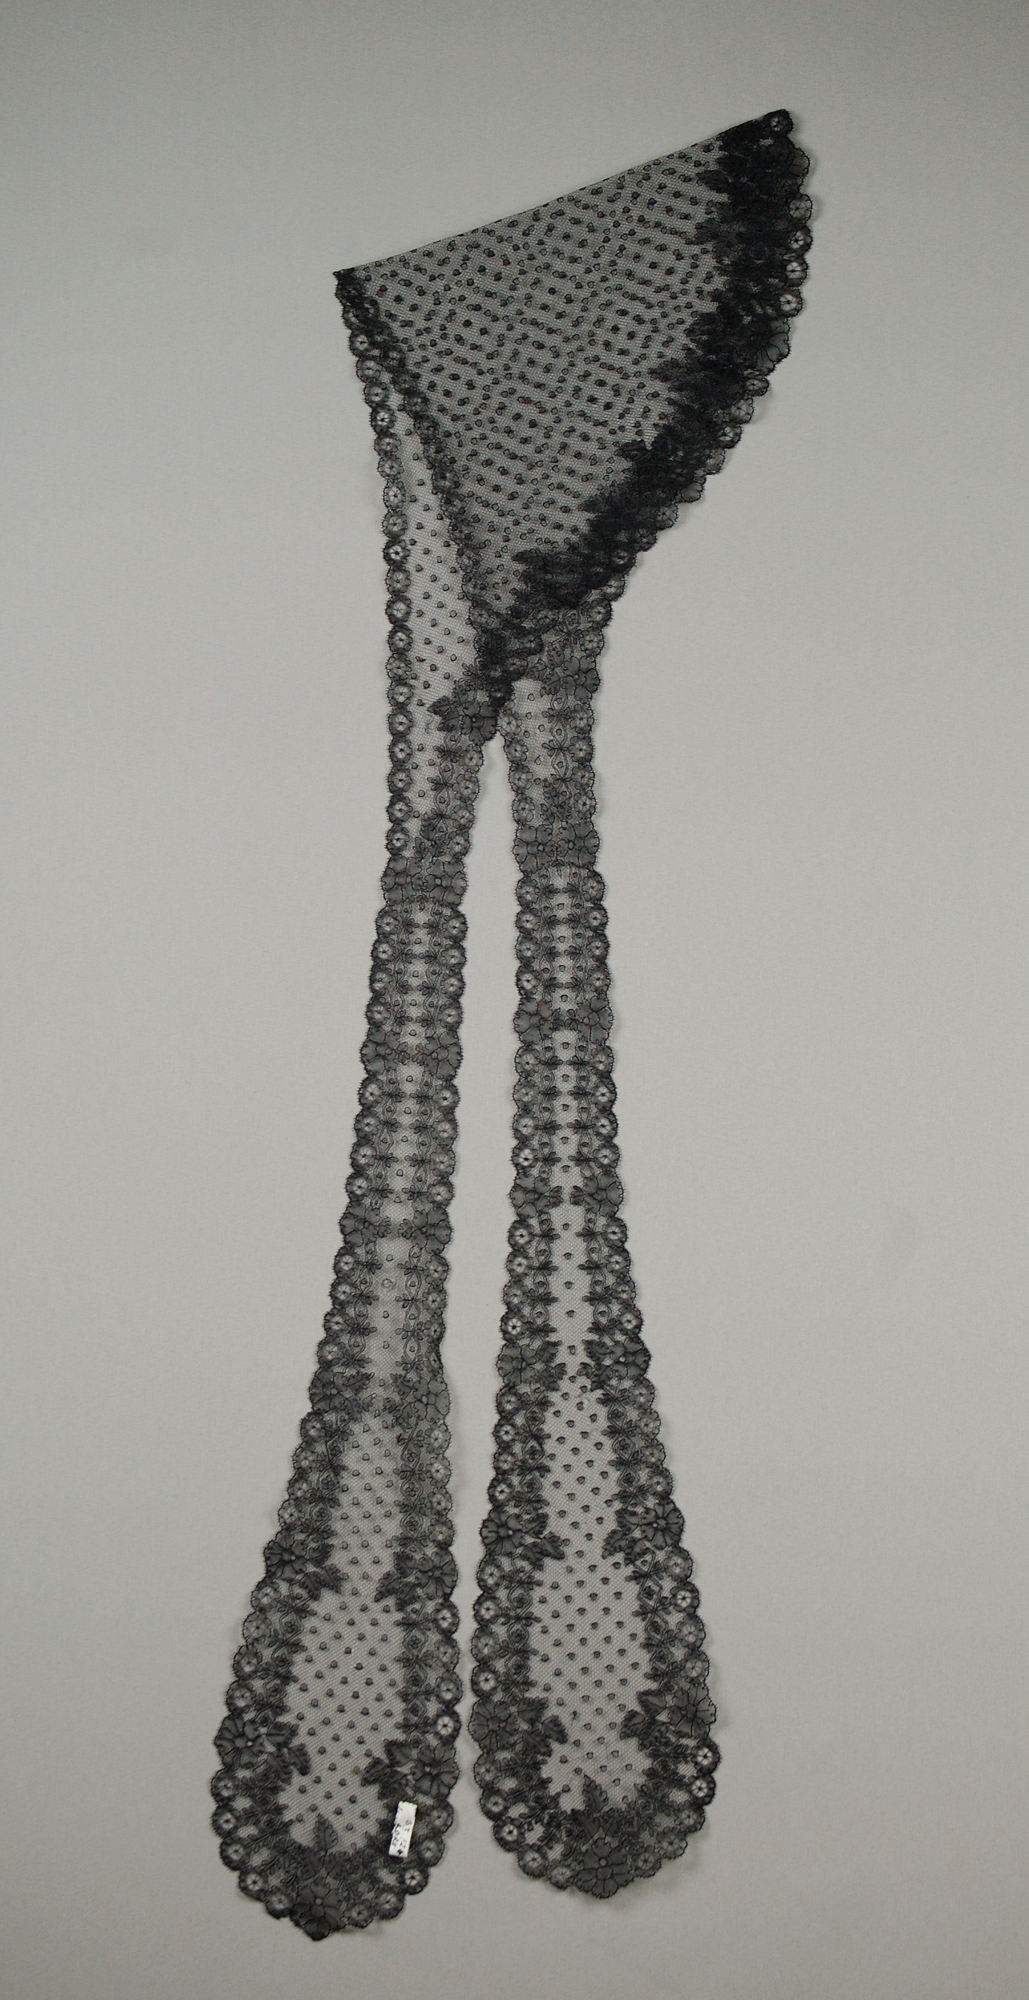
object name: fanchon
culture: american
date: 1860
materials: silk